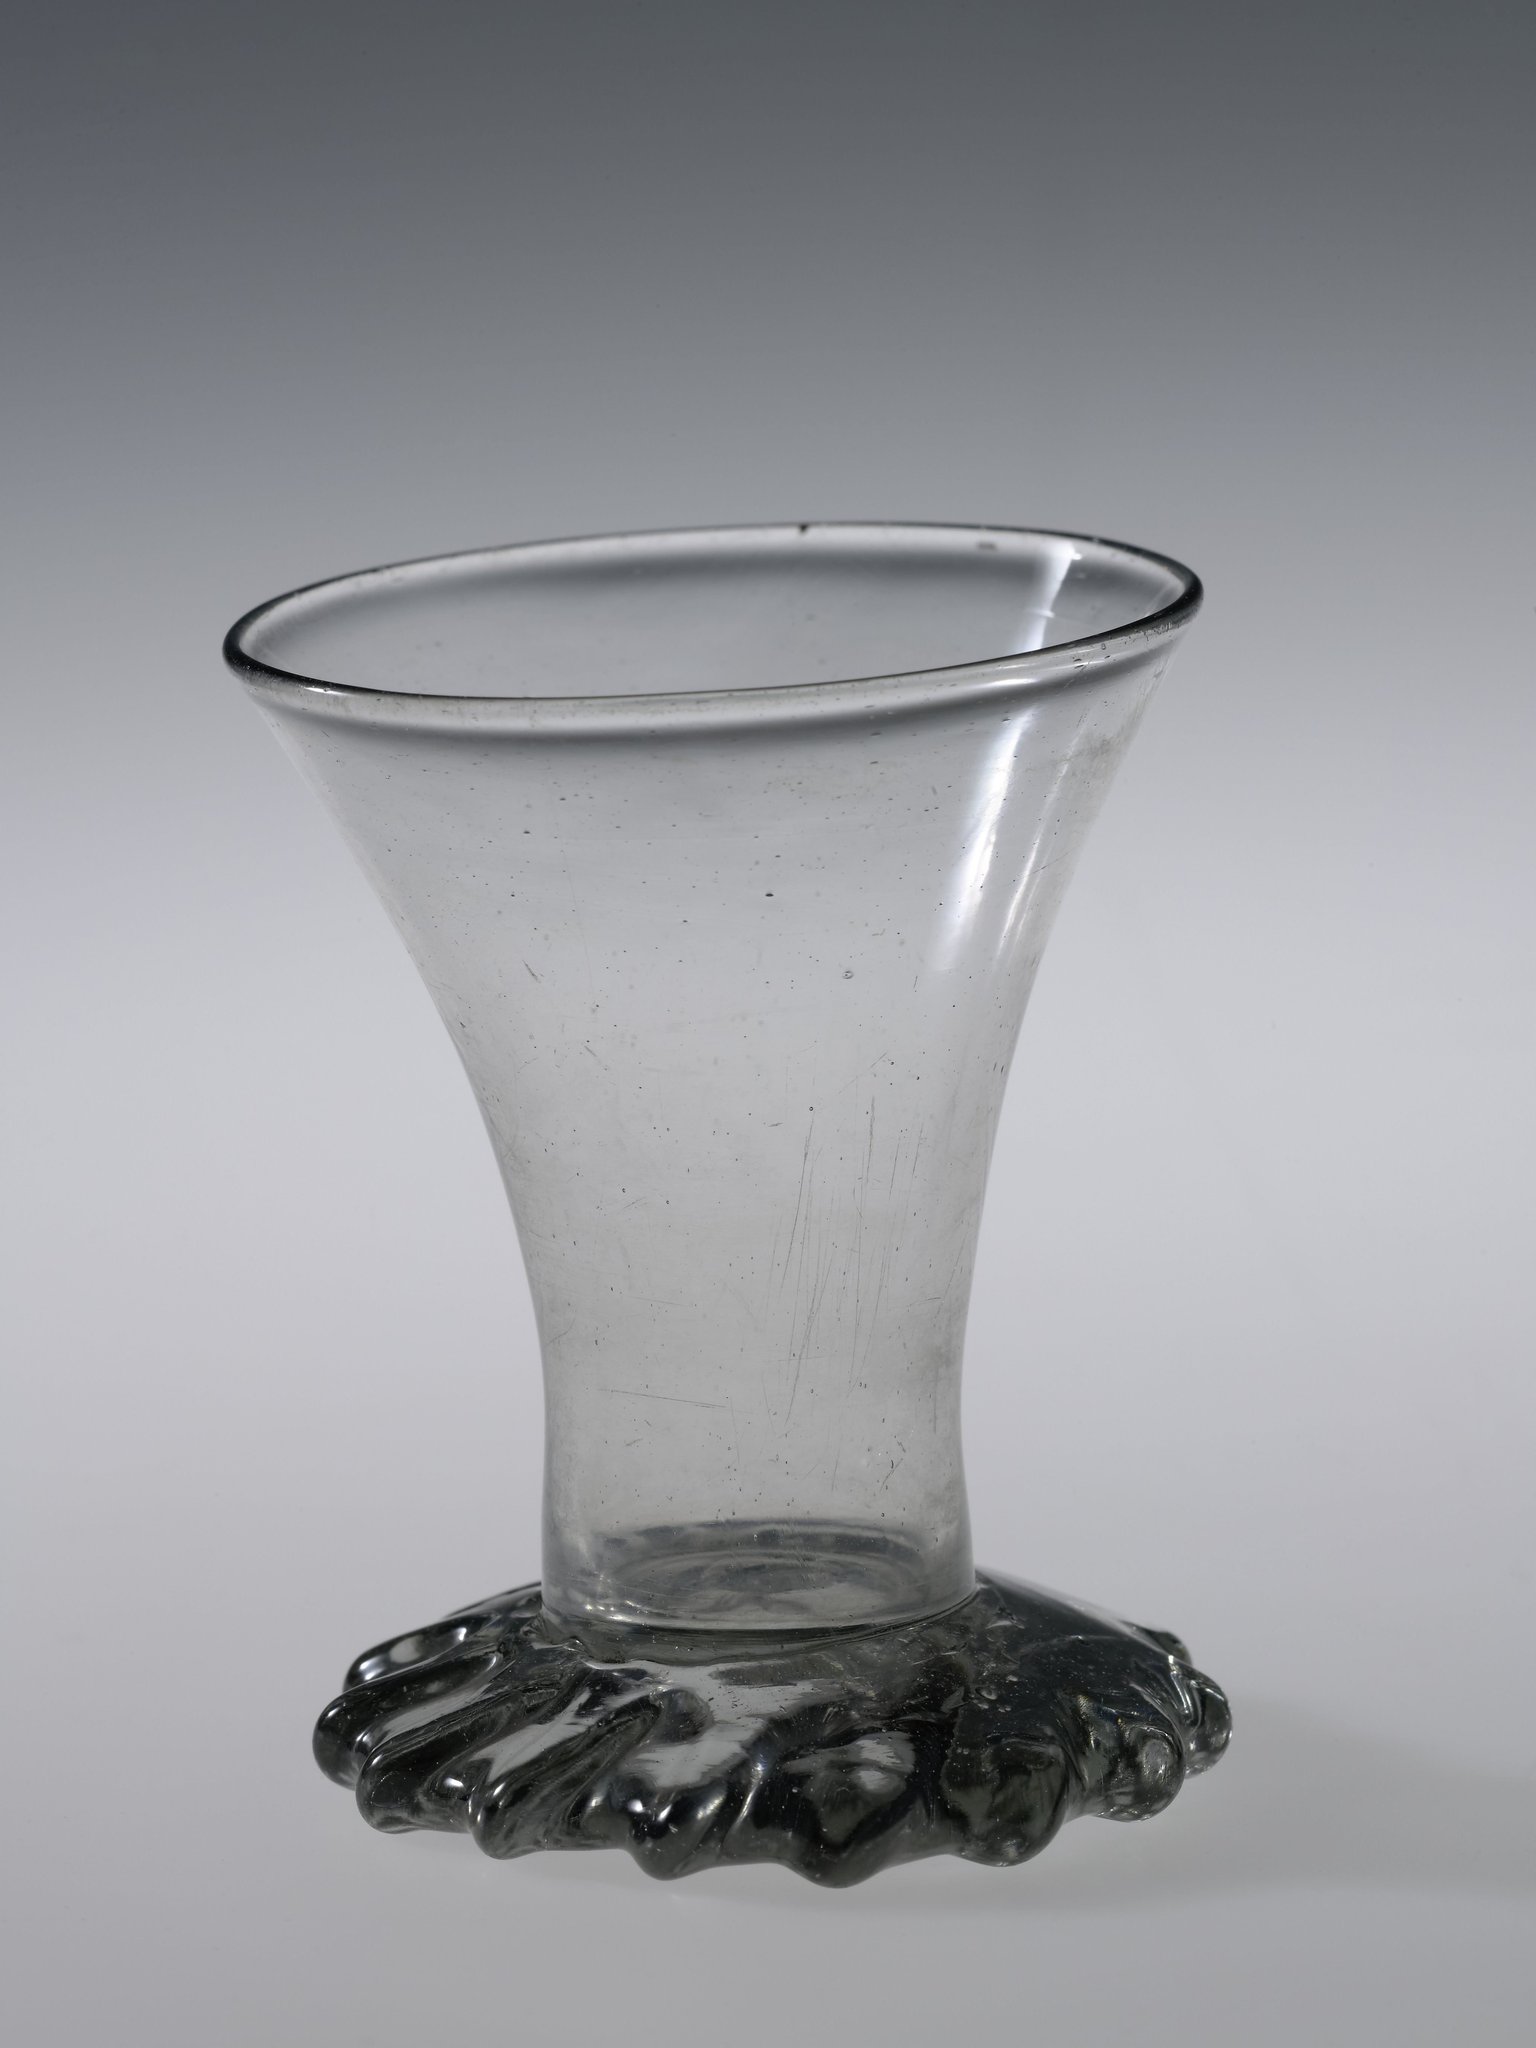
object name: cup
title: Beker op gelobde voet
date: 1750-1774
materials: glass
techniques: glassblowing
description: Kleine beker op gelobde voet en trompetvormige kelk.